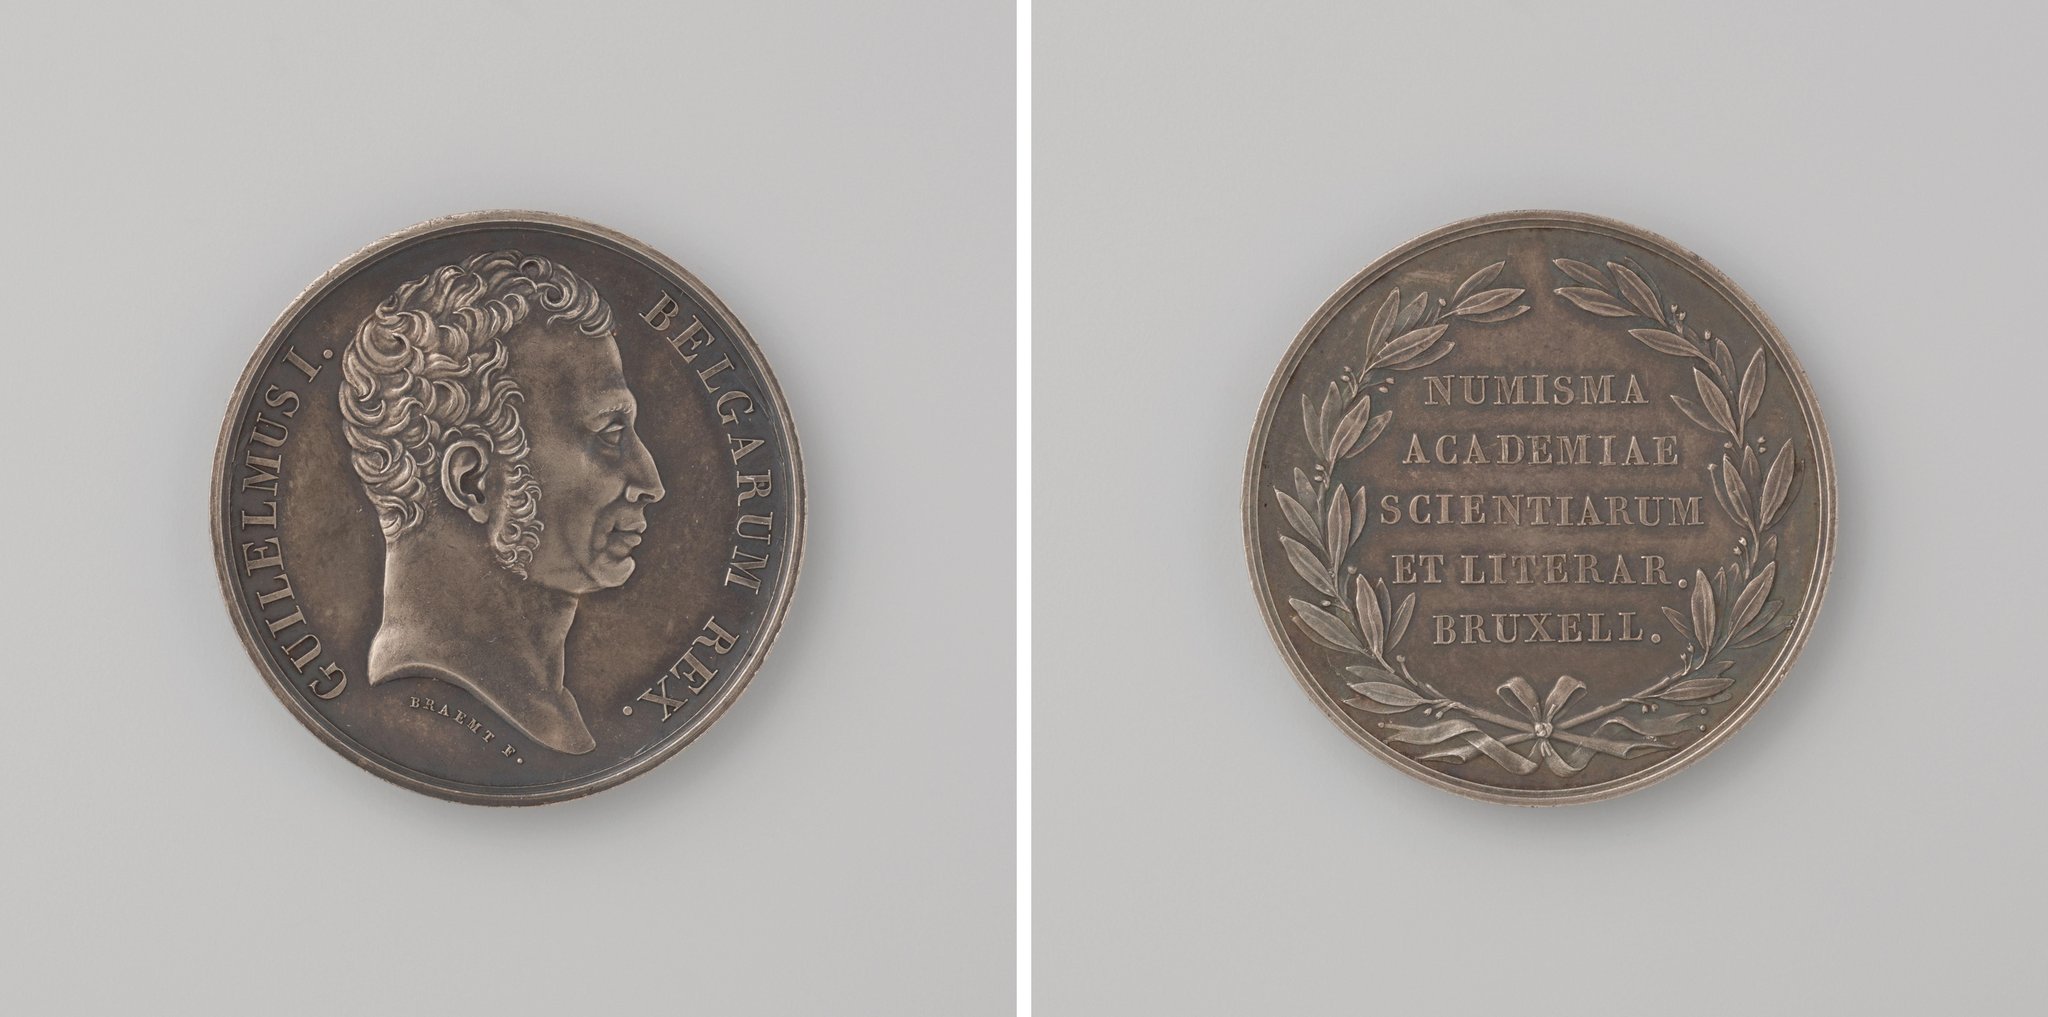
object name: medal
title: Koninklijke Academie van Wetenschappen en Letteren te Brussel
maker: joseph pierre braemt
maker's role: print maker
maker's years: 1796-1864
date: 1816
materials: silver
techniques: striking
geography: brussels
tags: the hague, berlin, william i of the netherlands, brussels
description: Zilveren penning. Voorzijde: borststuk man binnen omschrift. Keerzijde: opschrift binnen krans van olijftakken